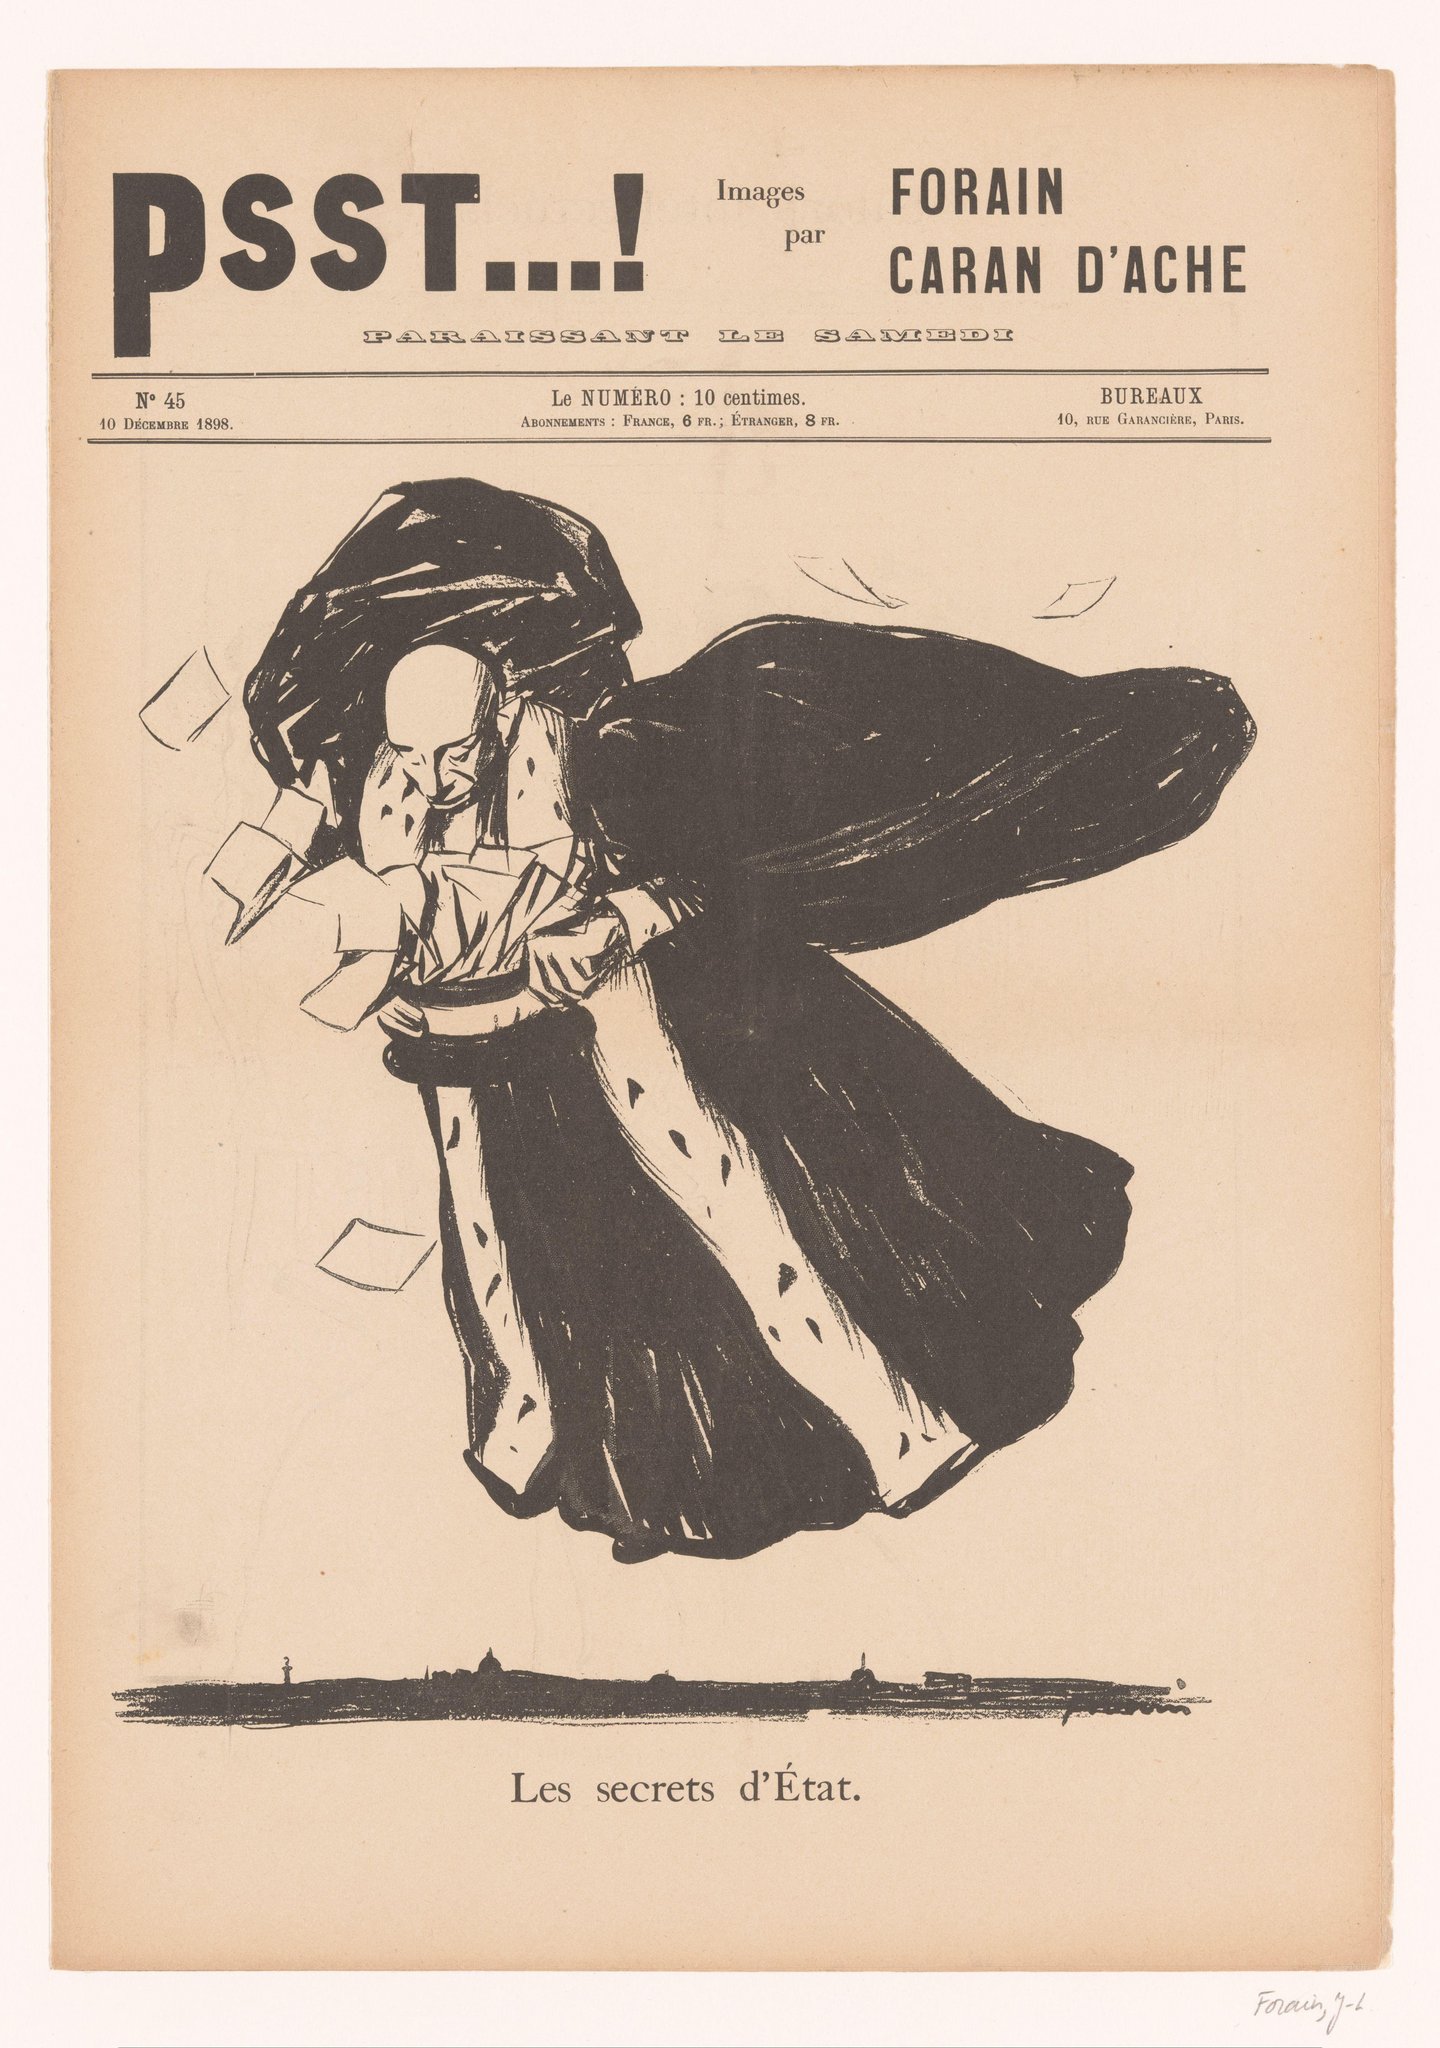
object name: cartoon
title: Karikatuur van de Staat als koning met een pet vol geheime brieven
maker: jean-louis forain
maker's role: painter, print maker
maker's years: 1852-1931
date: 1898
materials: paper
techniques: lithograph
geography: paris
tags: official; civil servant; functionary (in general), letter, envelope, political caricatures and satires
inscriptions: date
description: Prent gebruikt voor: Psst...!, nr. 45, 10 december 1898. Psst..! was een politieke weekkrant met antisemitische en anti-Dreyfus cartoons.